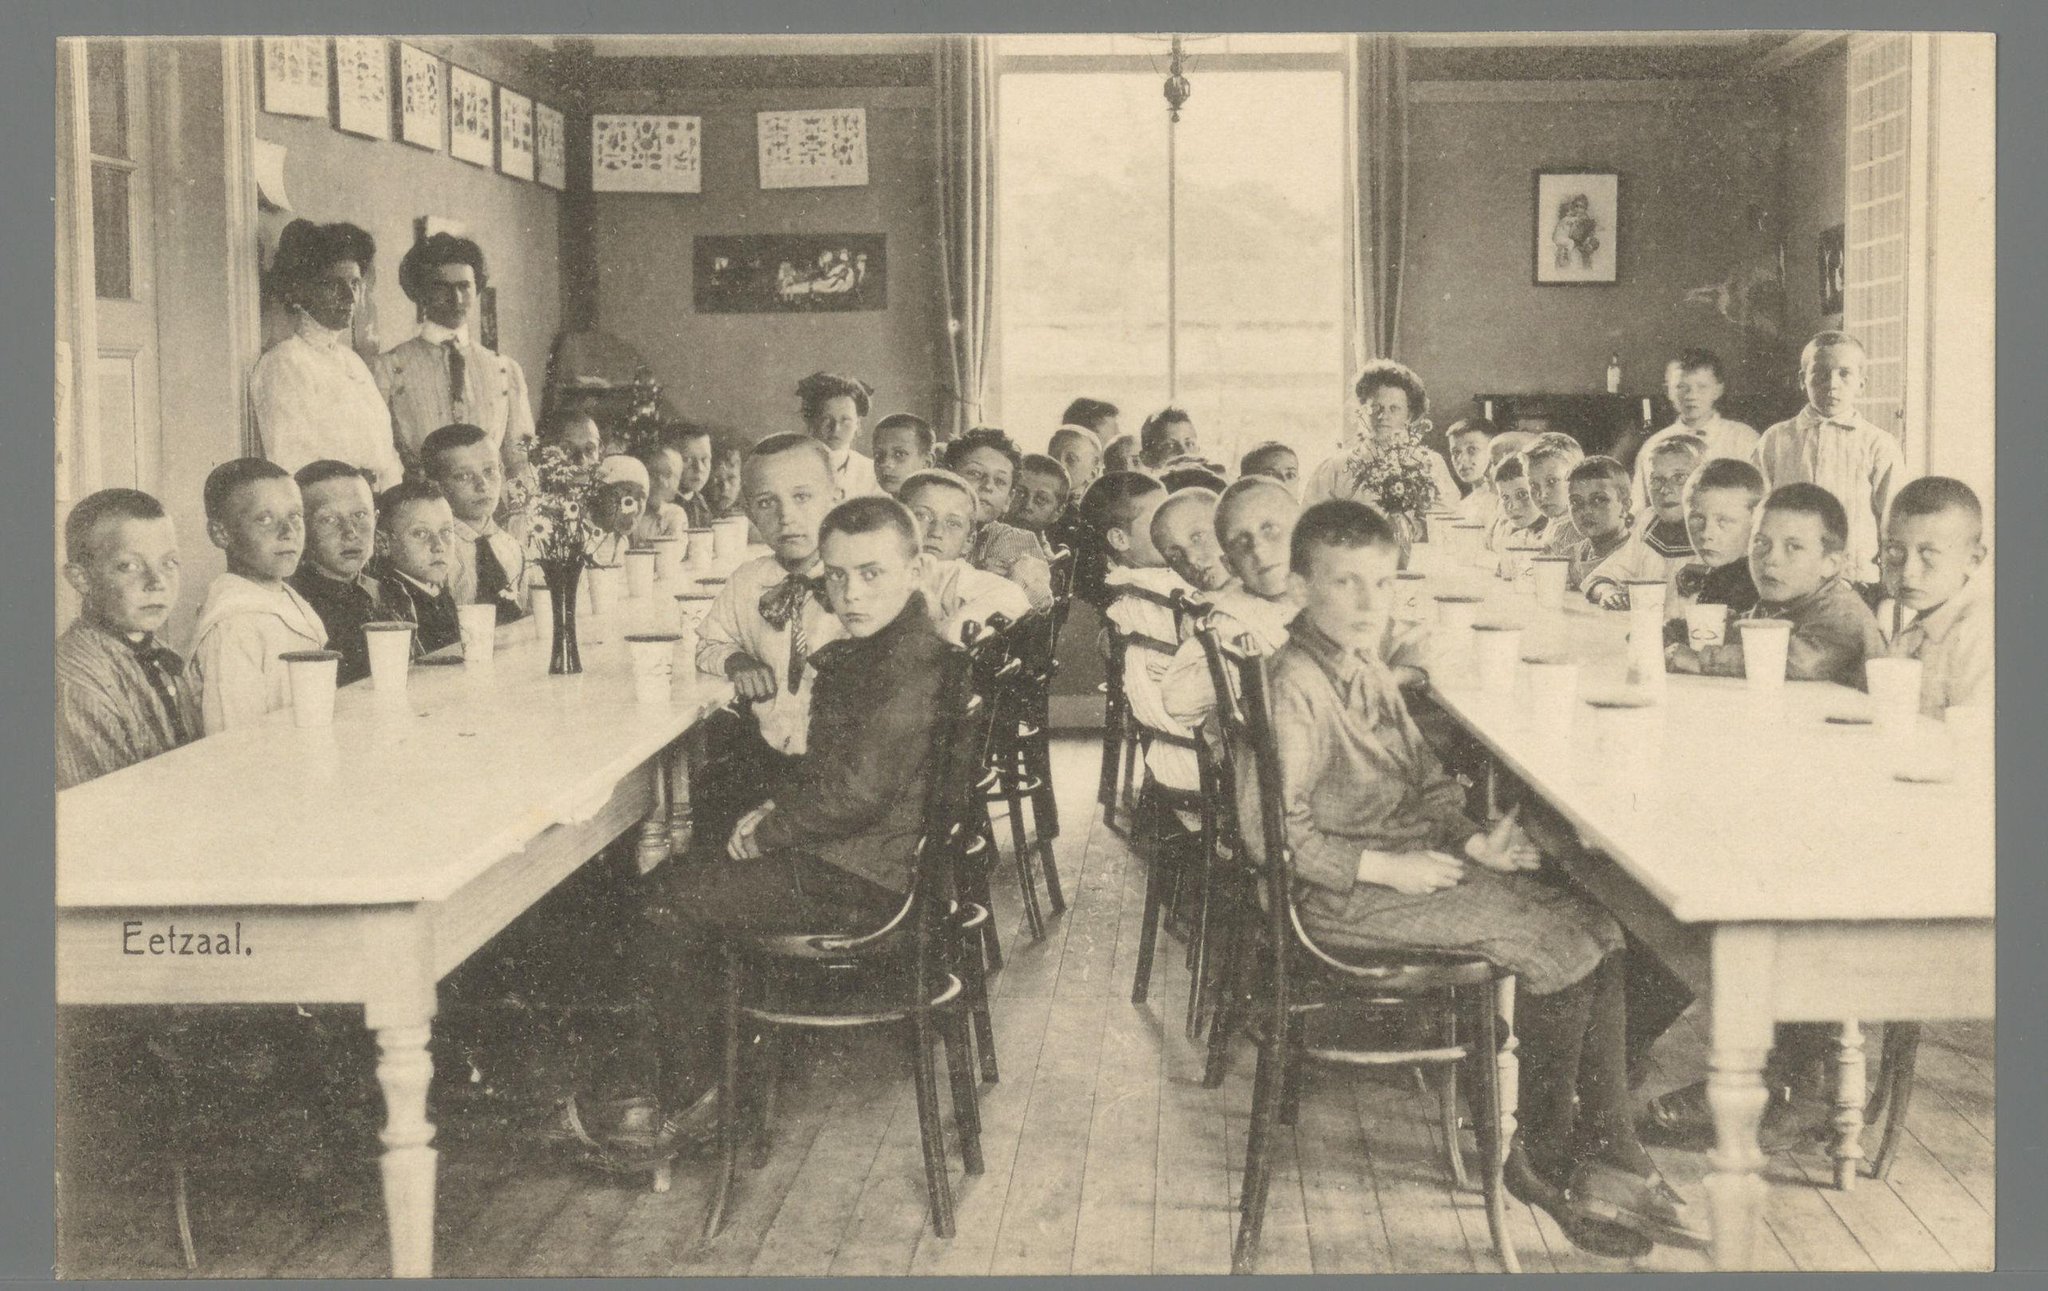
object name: photomechanical print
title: Eetzaal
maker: Anonymous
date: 1905-1915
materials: cardboard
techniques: photograph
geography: bosch en duin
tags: interior of the house, recovery, convalescence of sick person